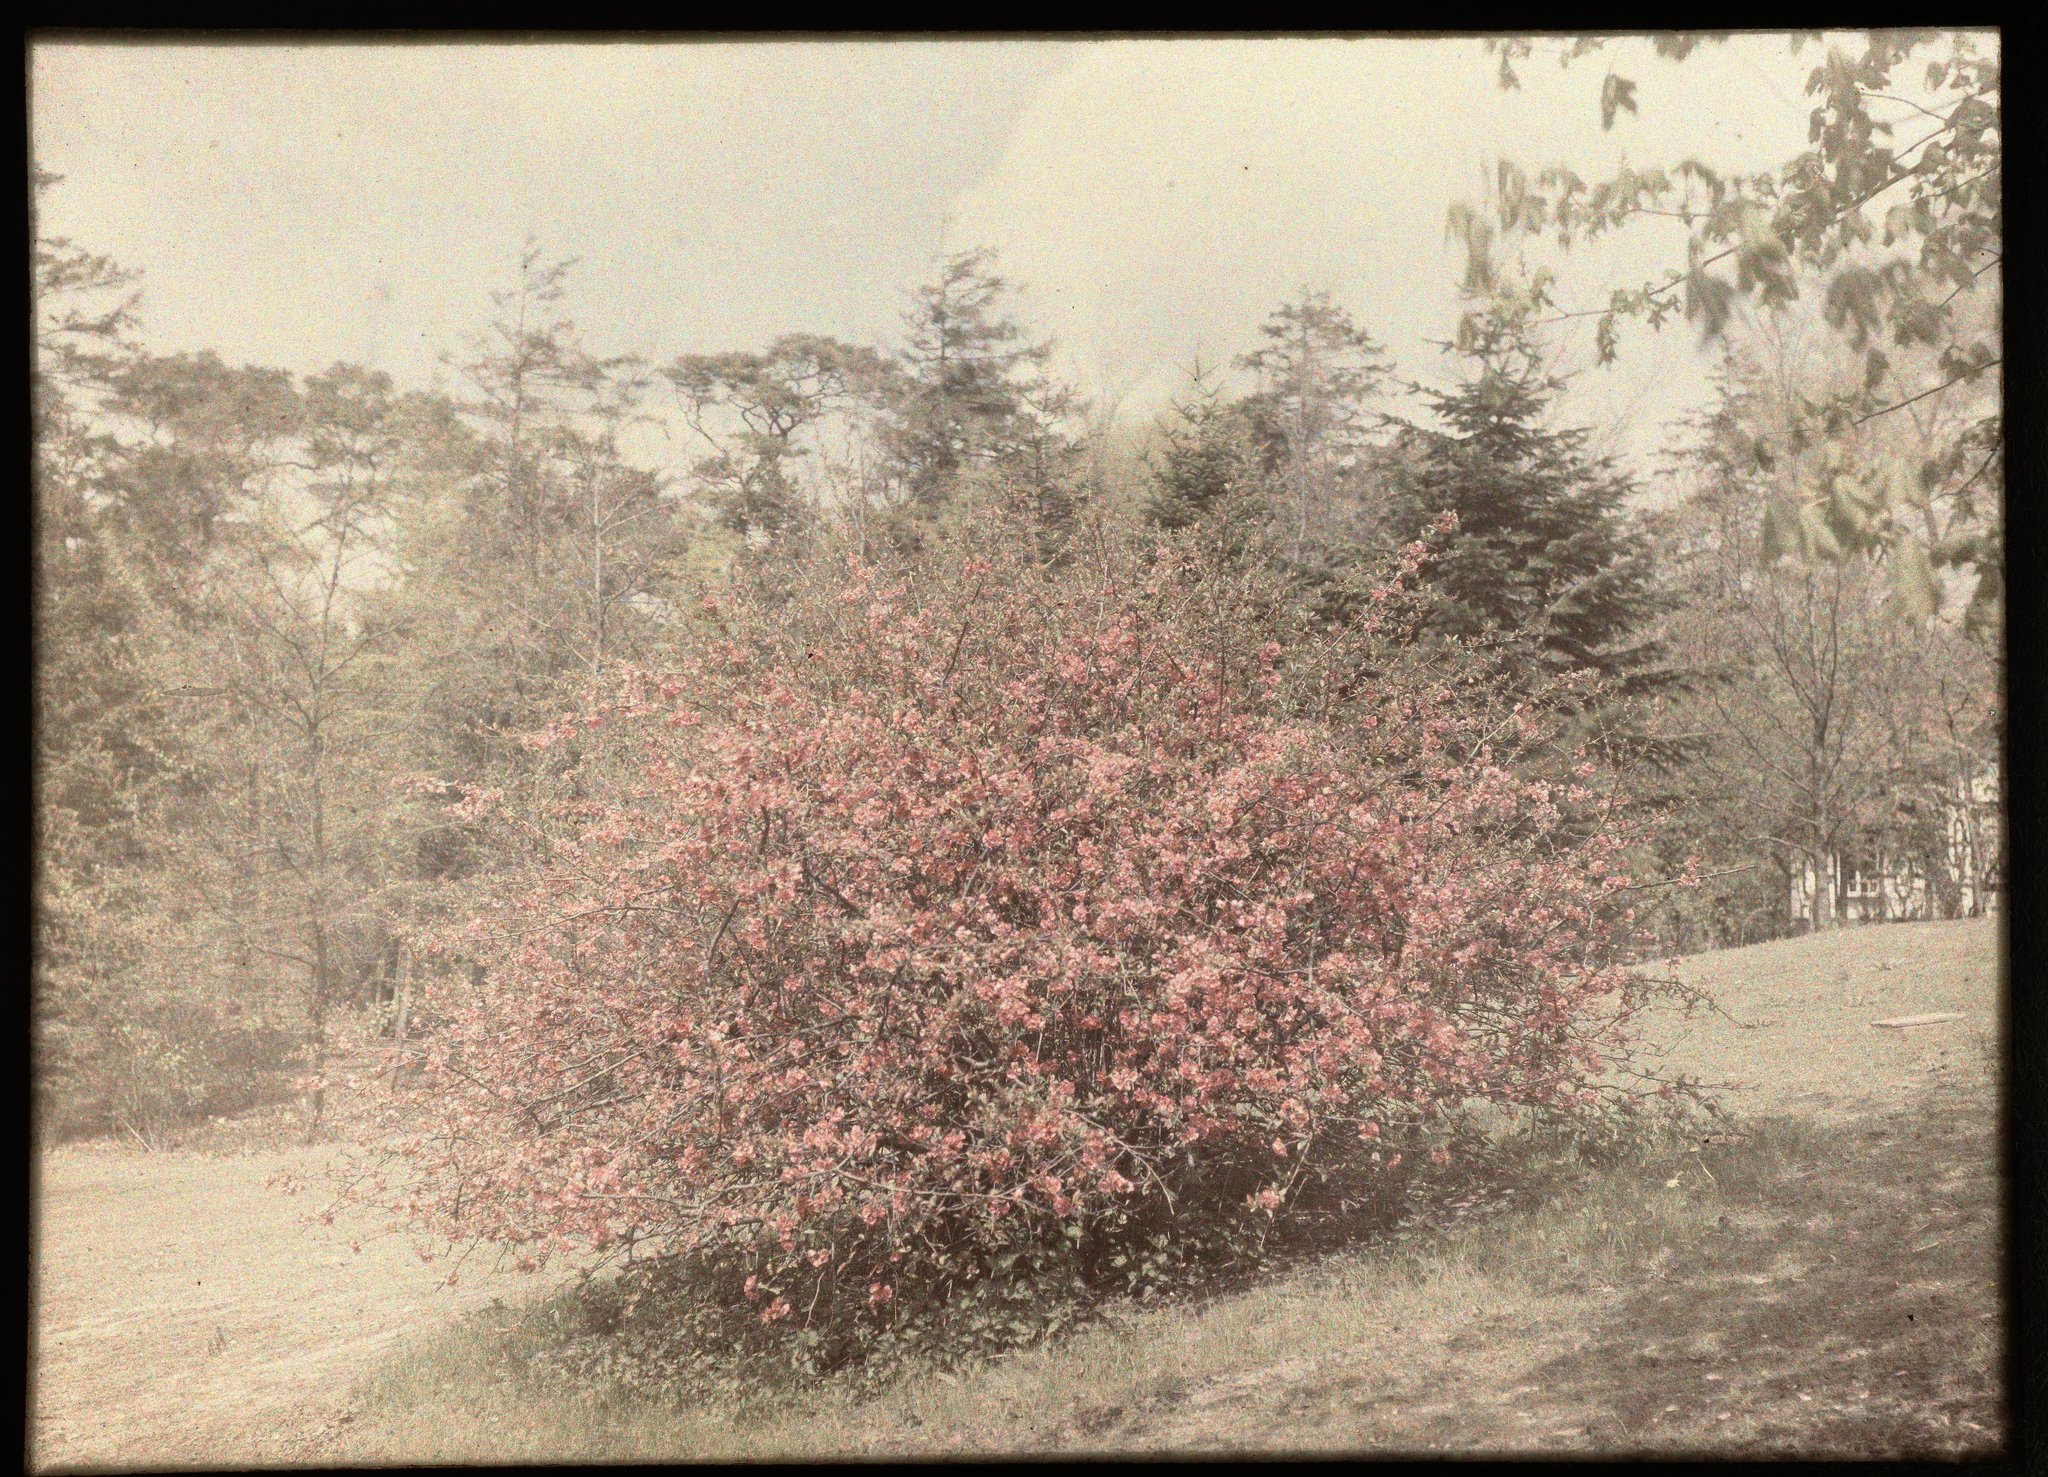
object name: color slide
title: Een rood bloeiende struik in een tuin of park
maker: adolphe burdet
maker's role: fotograaf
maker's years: 1860-1940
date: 1907-1930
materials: glass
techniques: autochrome process, slide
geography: netherlands